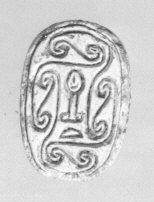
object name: stamp seal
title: Scarab seal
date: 1786-1650 BCE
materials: stone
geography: levant